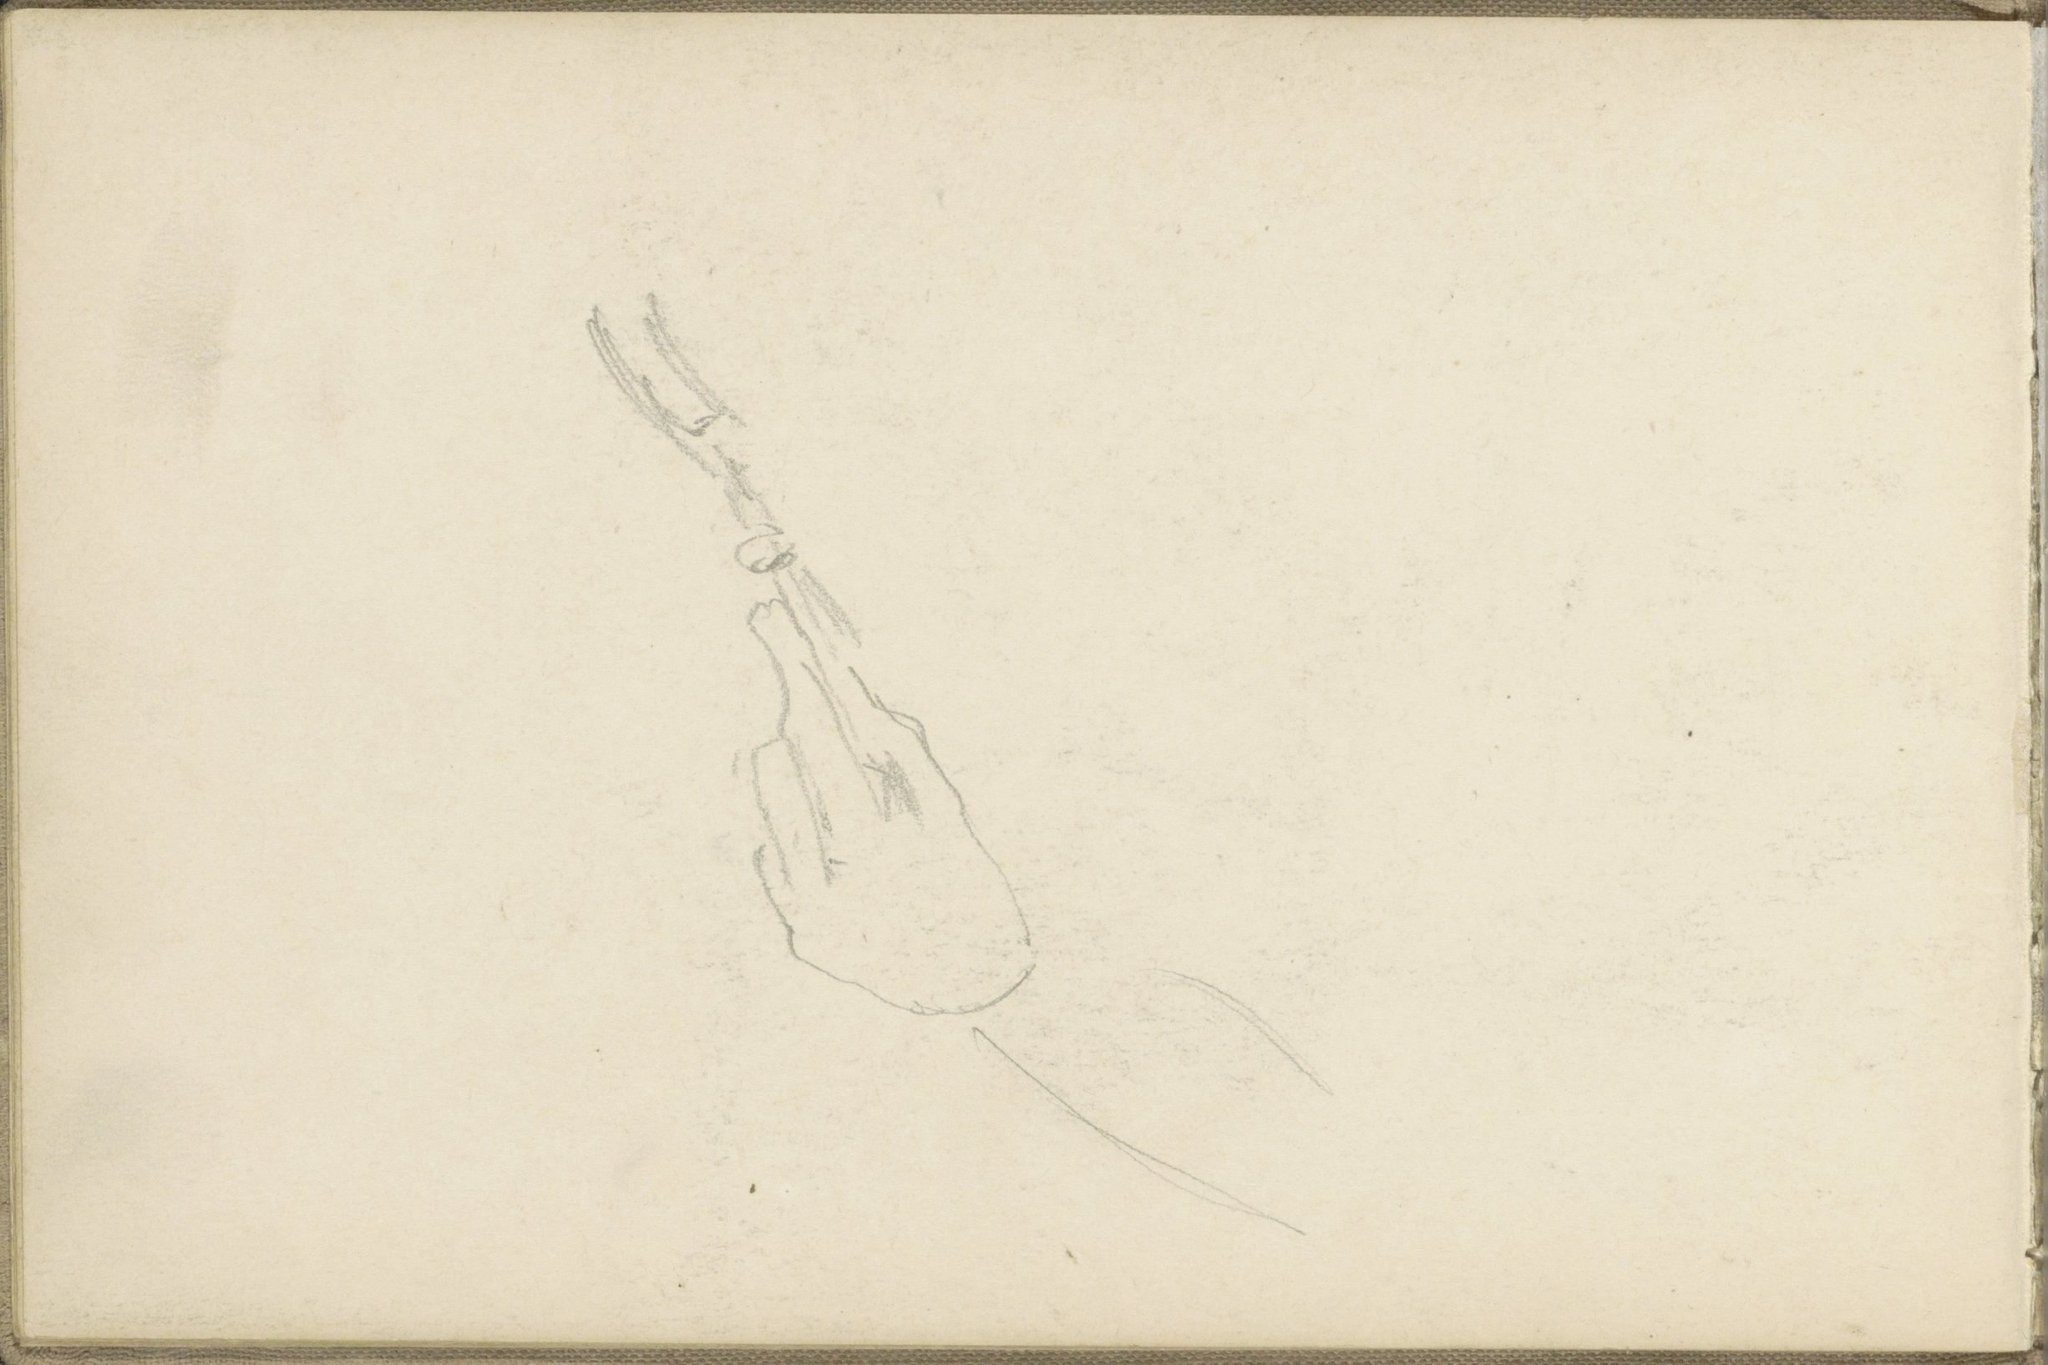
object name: sketchbook leaf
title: Hand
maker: carel adolph lion cachet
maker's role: draughtsman, print maker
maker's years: 1864-1945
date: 1905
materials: paper, pencil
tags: hand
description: Blad 7 verso uit een schetsboek met 27 bladen.